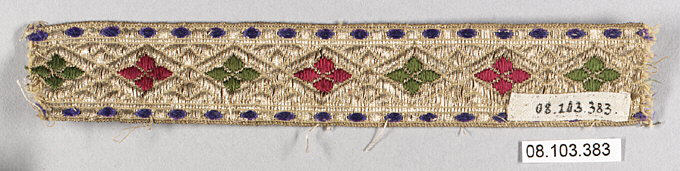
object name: galloon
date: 1601-1800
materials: metal thread, silk